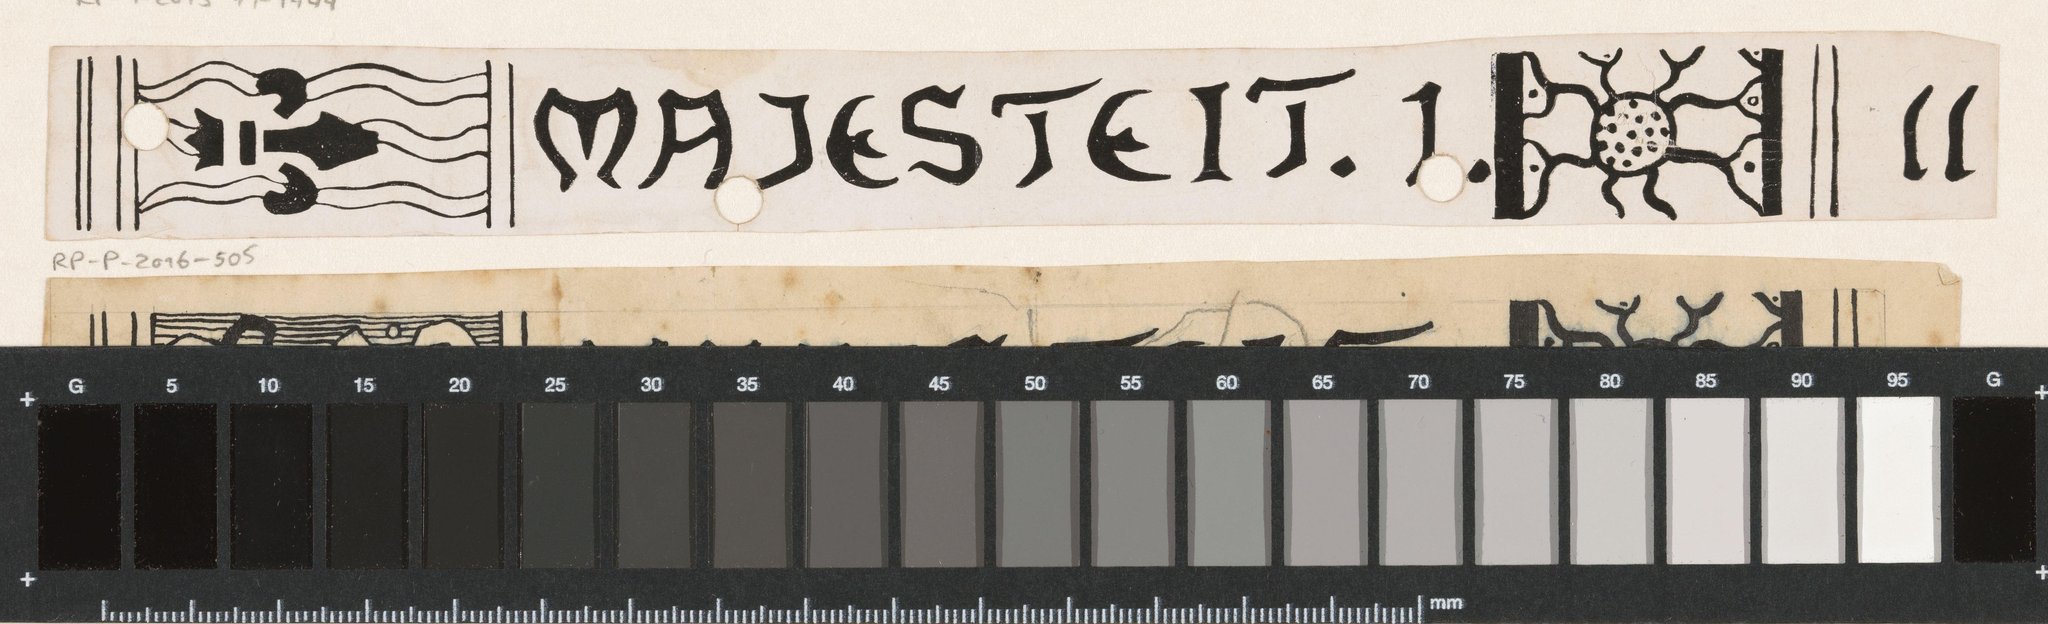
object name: photomechanical print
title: Ontwerp voor een boekrug voor: Louis Couperus, Majesteit, dl. 1, 1893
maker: Anonymous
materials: paper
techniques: printing block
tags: fleur-de-lis ~ ornament, fancy letters, flowers ~ ornament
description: Ontwerp voor een boekrug met de boektitel en aan weerszijden een motief van een fleur-de-lis tussen drie wortels en een bloem.